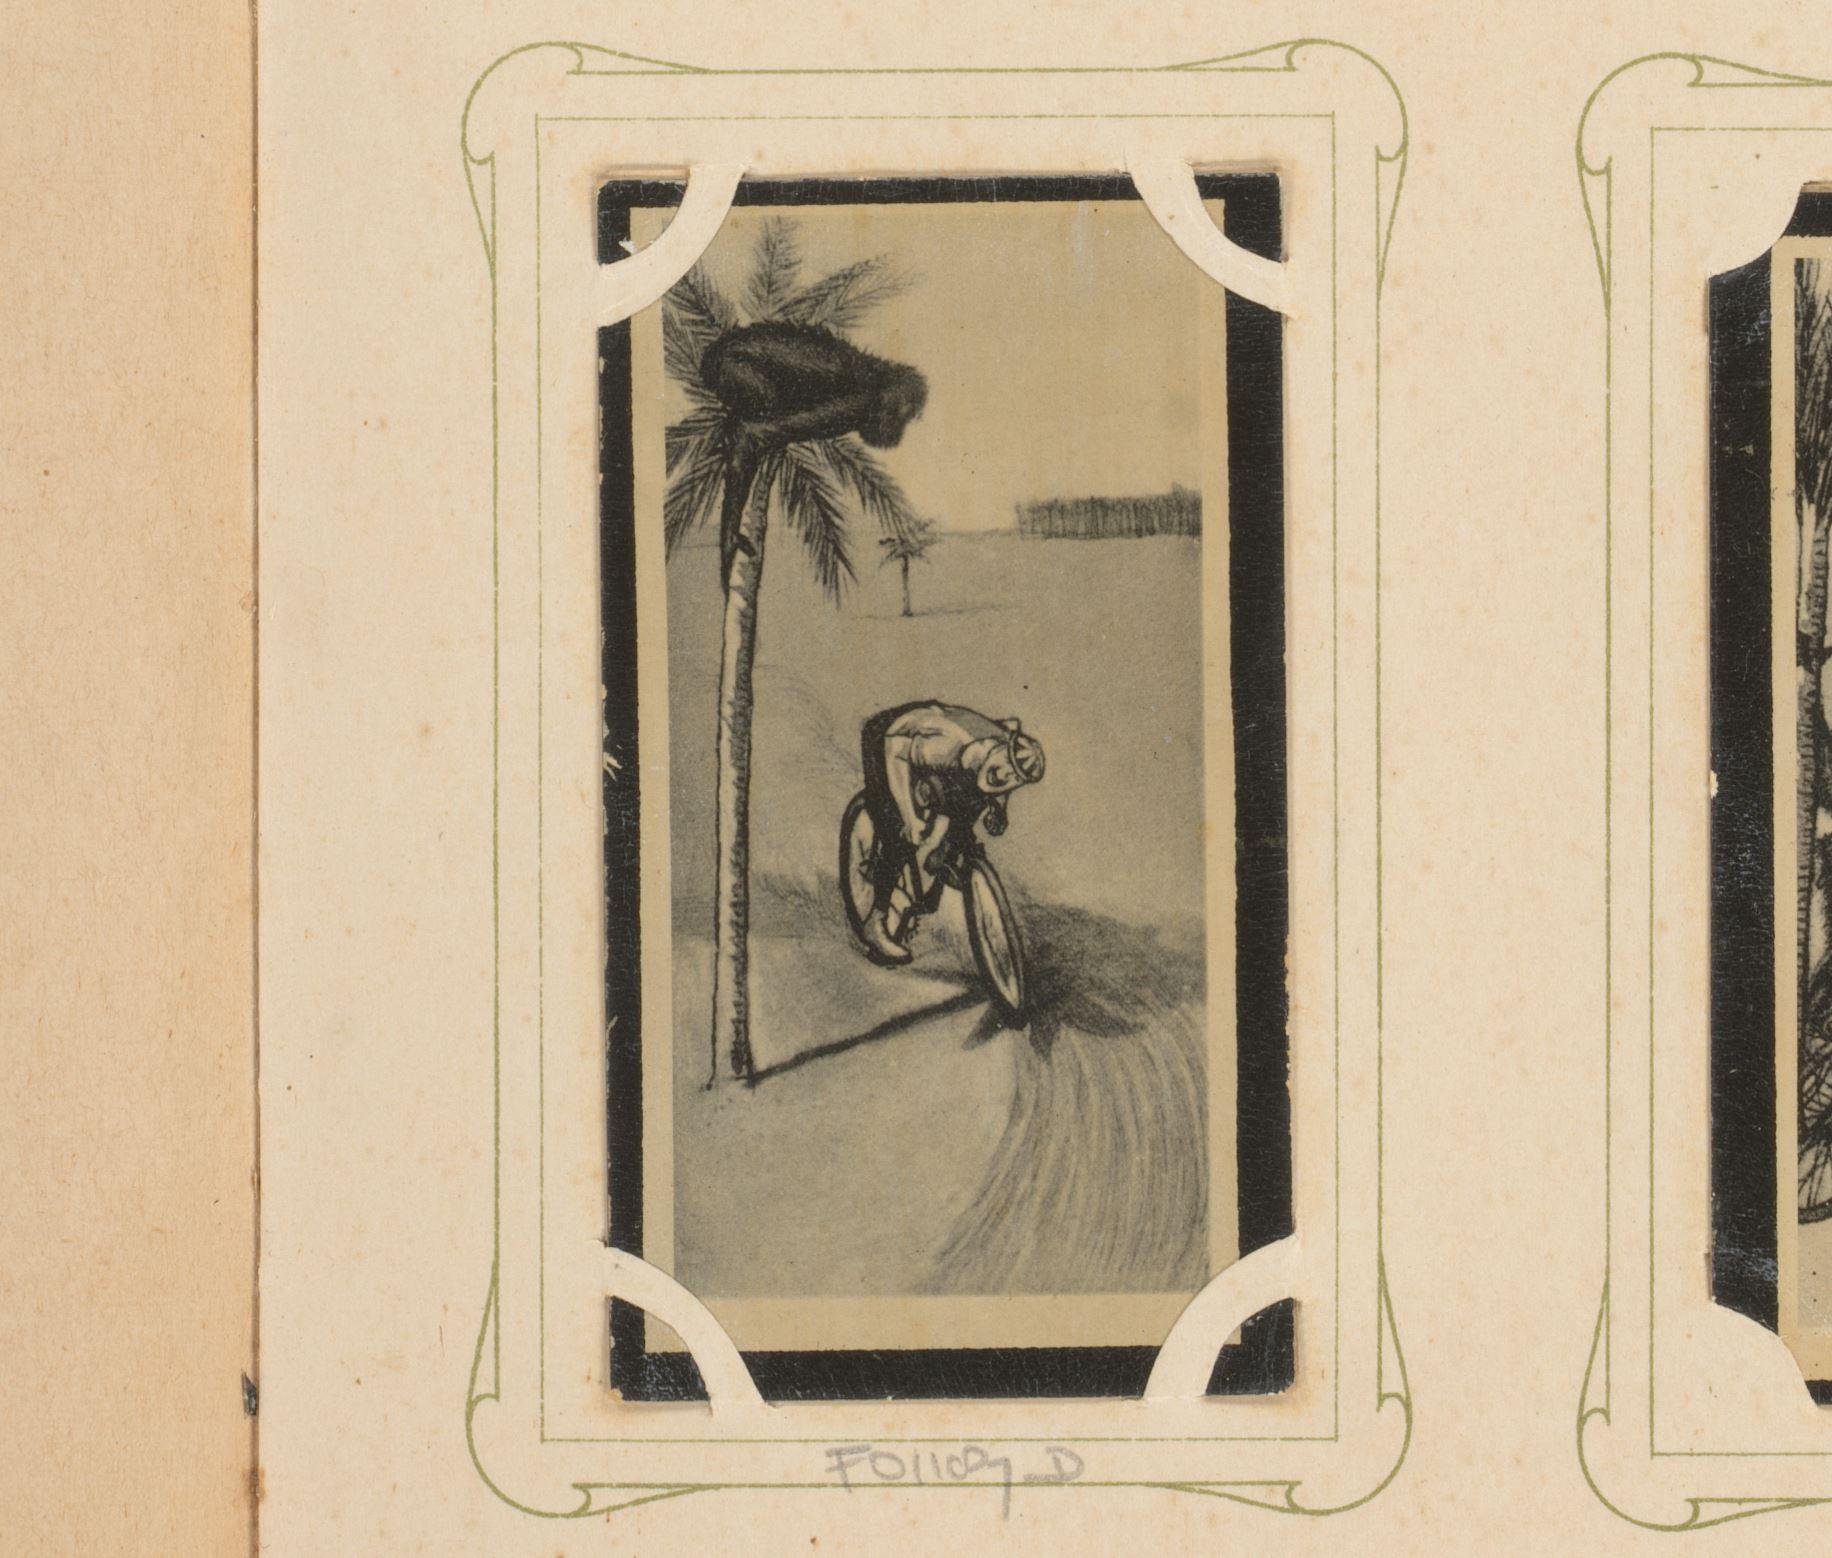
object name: album leaf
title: Reproductie van een tekening van een jongen die fietst voor een aap in een boom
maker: Anonymous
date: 1905-1906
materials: paper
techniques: photograph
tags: trees, monkeys, apes, youth, adolescent, bicycle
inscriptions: inscription: ‘No. 4./ Nu eens proberen of dit ook lukt.’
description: Deze prent maakt deel uit van een album.